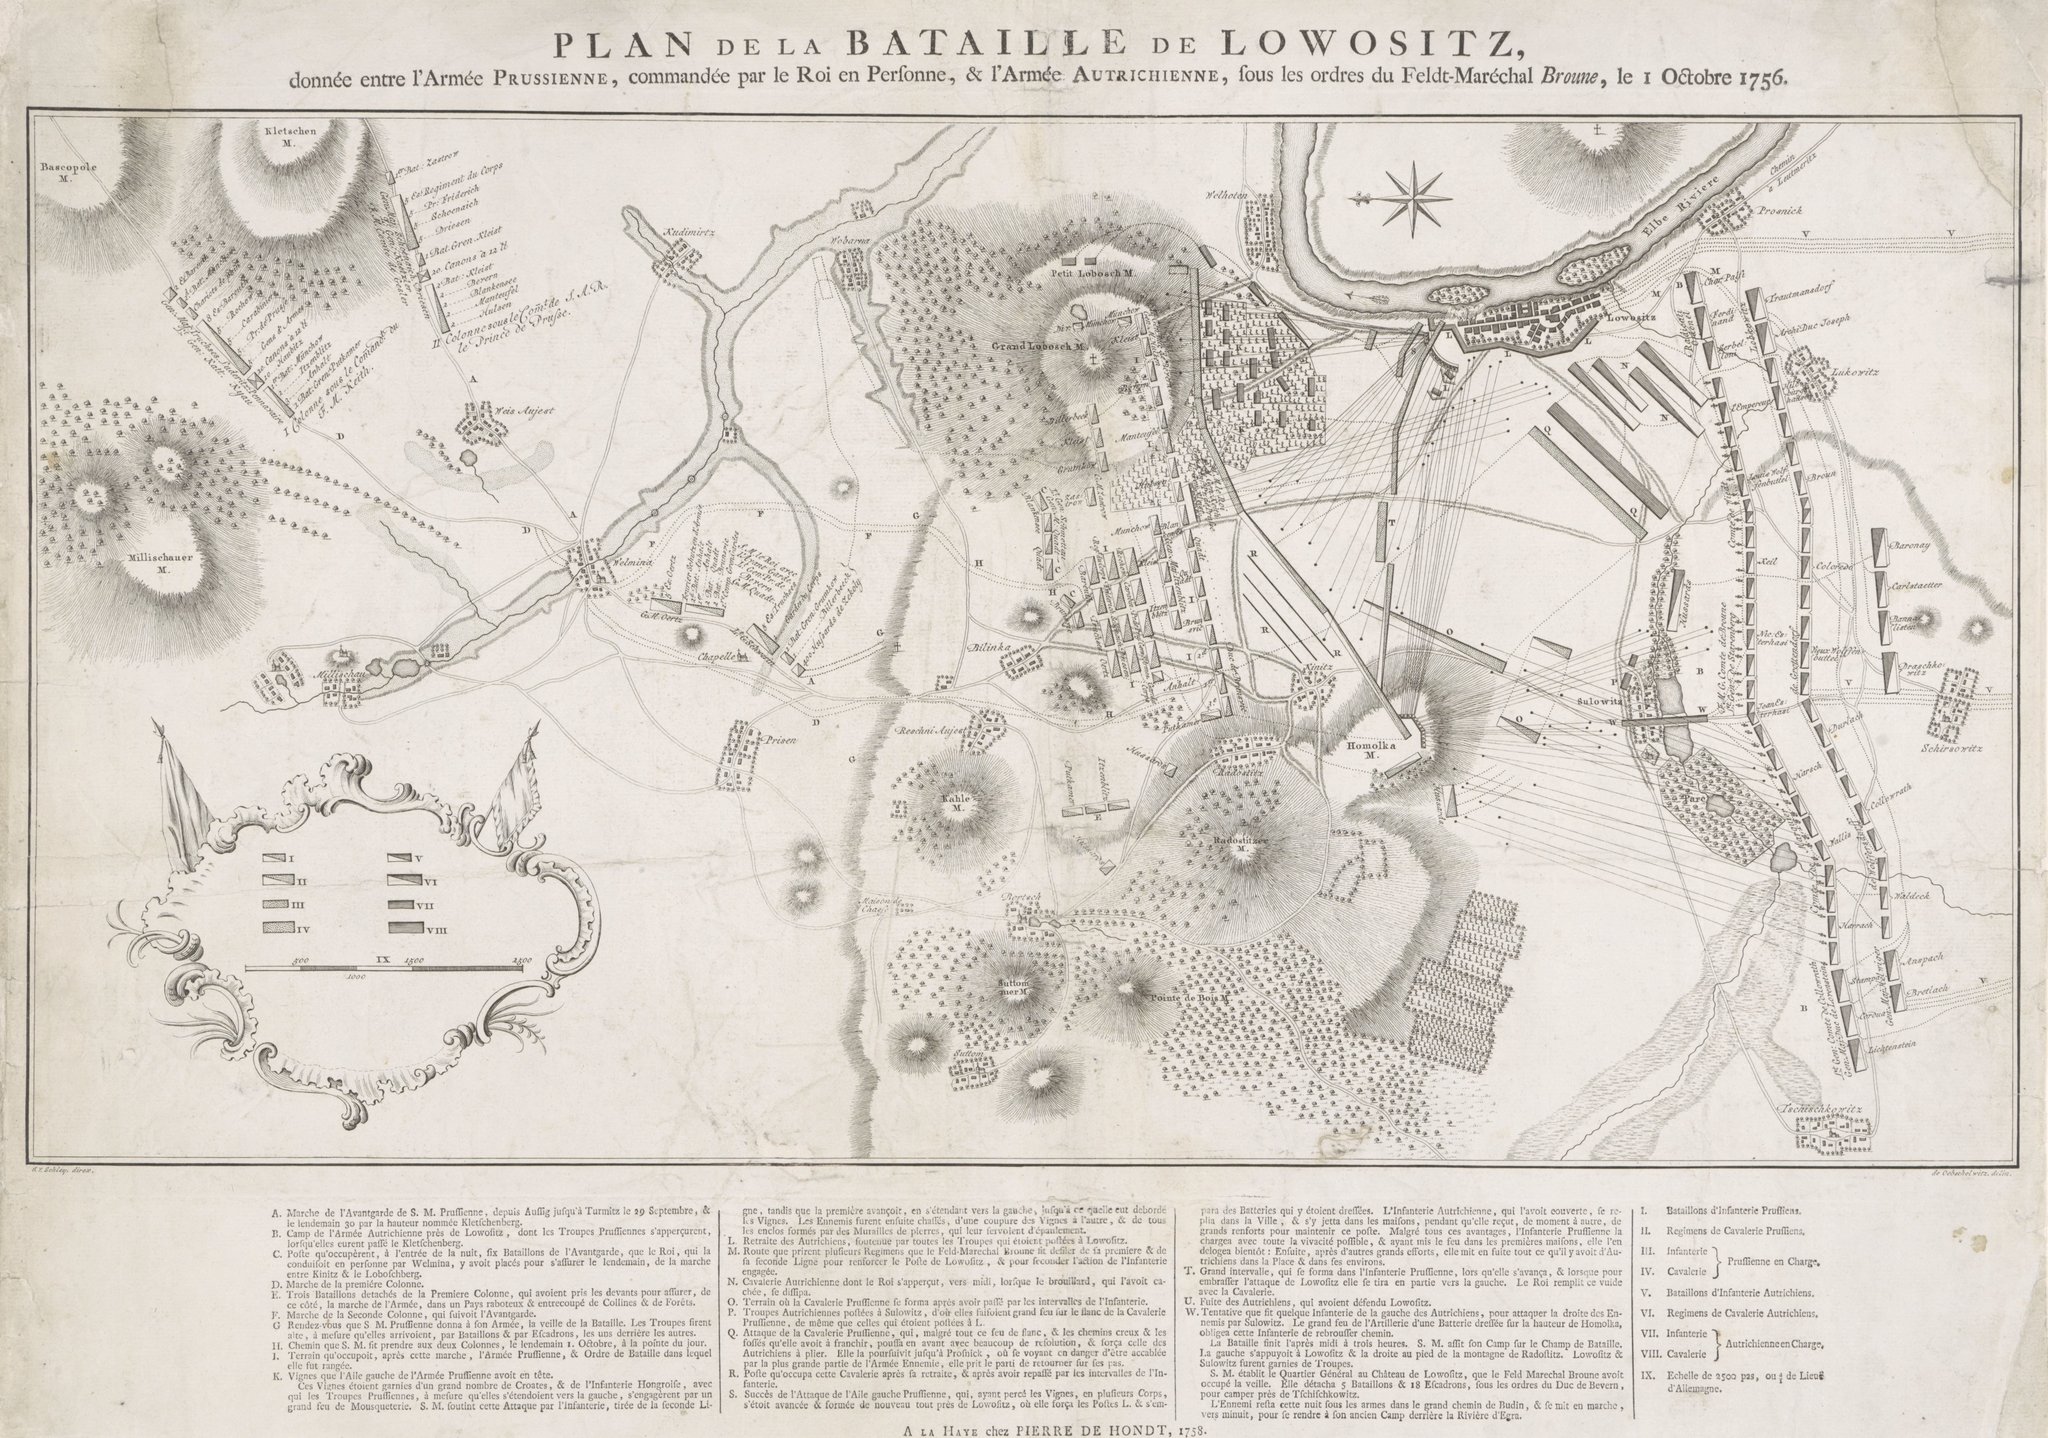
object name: print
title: Militaire plattegrond van Lobositz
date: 1758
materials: paper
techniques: etching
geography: the hague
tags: warfare; military affairs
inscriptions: collector's mark: Lugt 2228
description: Militaire plattegrond van Lobositz (Tsjechische Republiek) met de strijd van 1 oktober 1756 tussen de Pruisen en de Oostenrijkers. Deze strijd was de openingsslag van de Zevenjarige Oorlog (1756-1763).